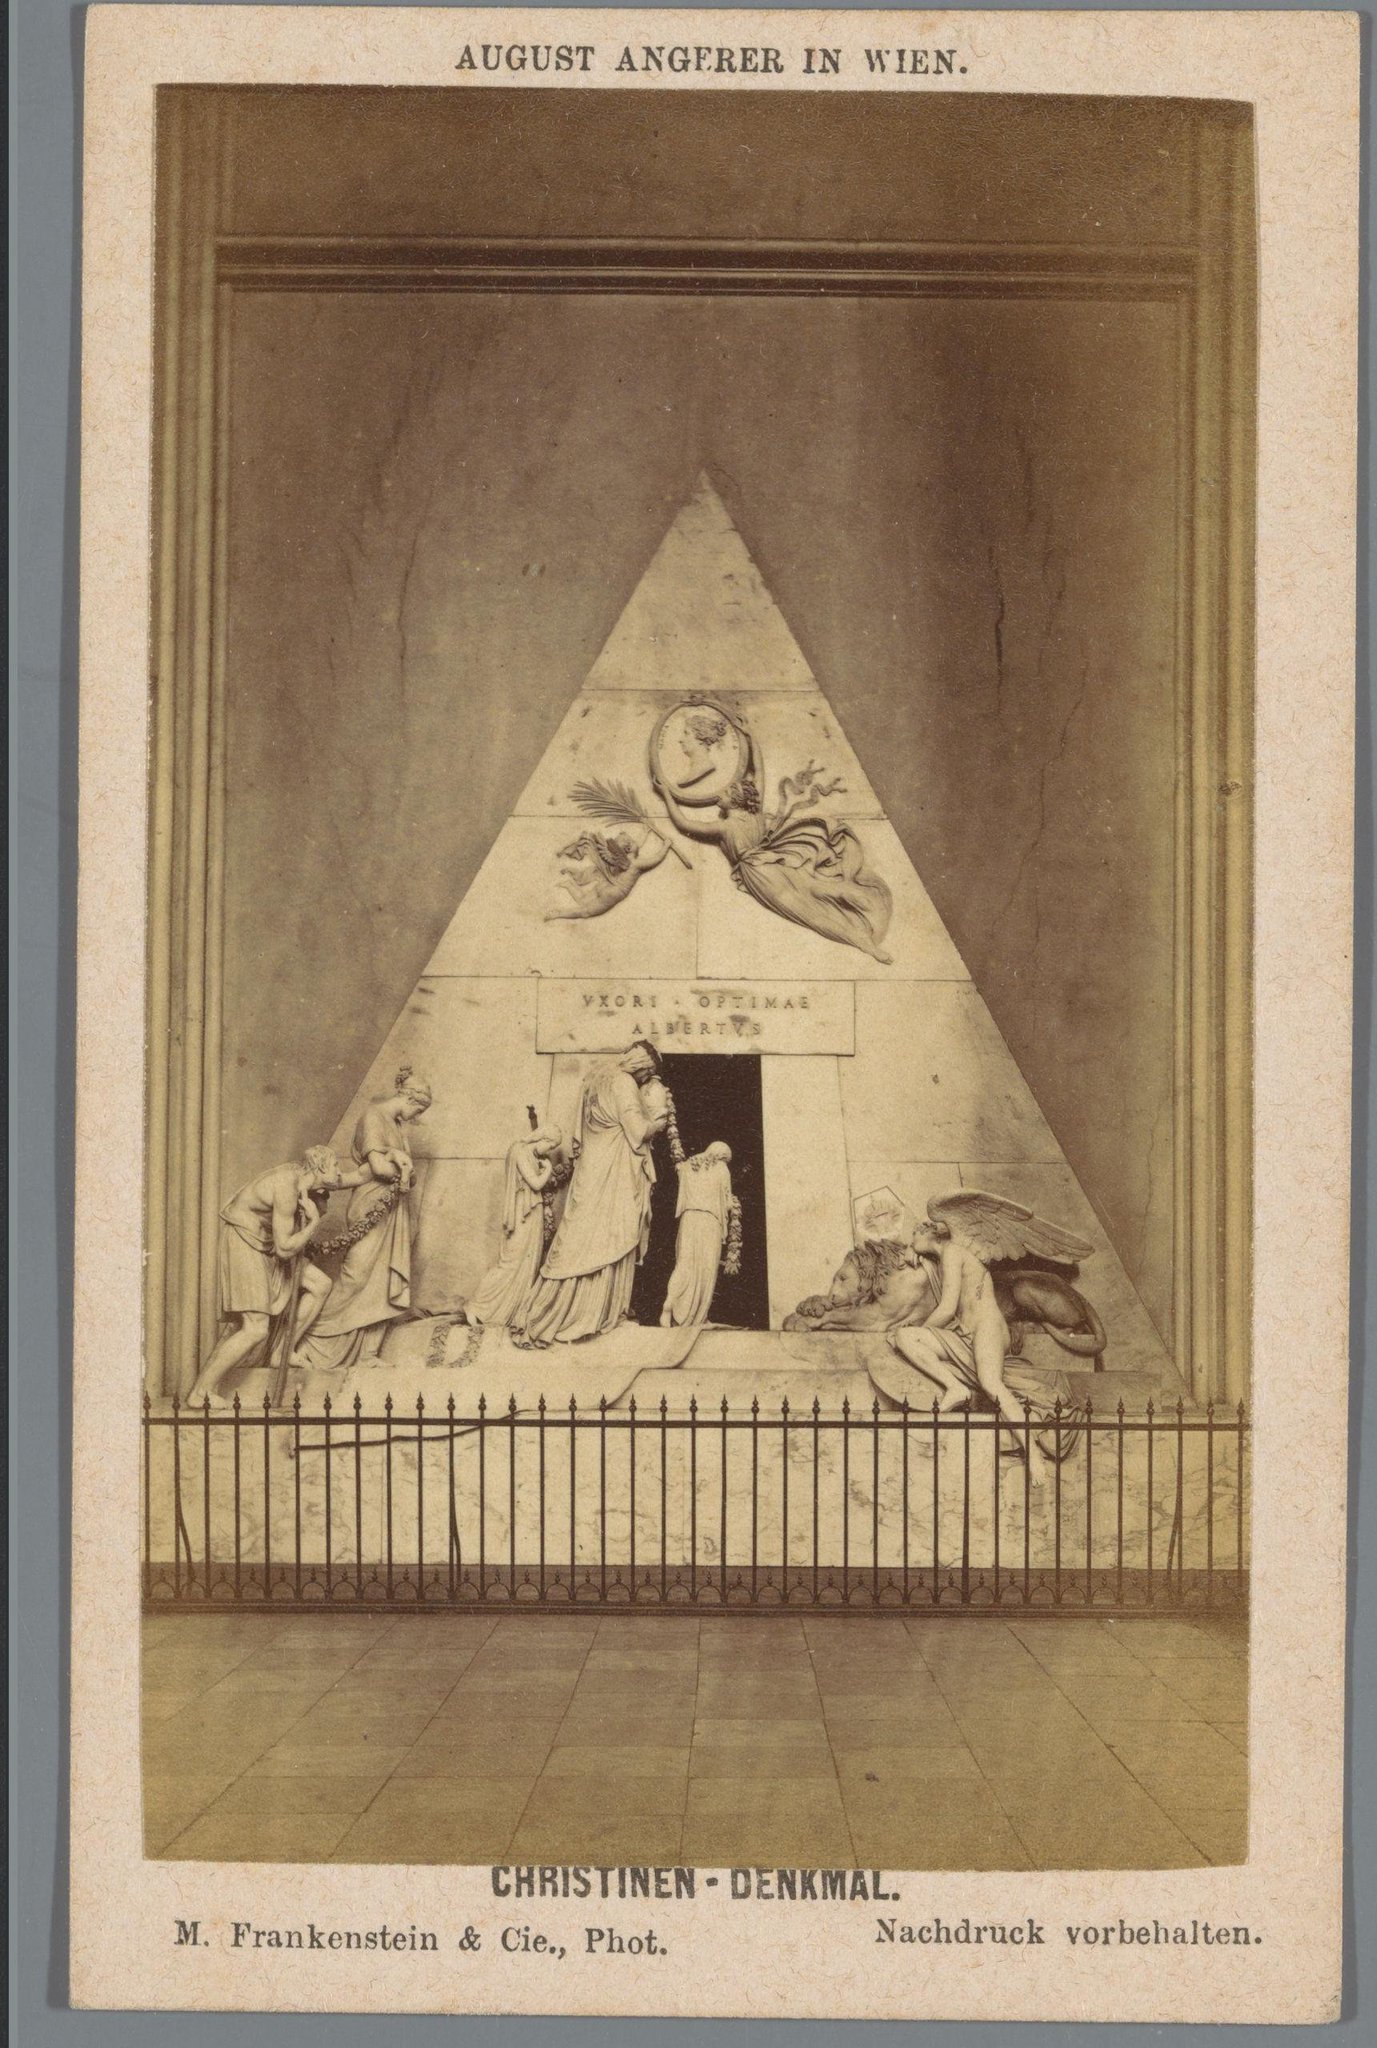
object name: photograph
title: Grafmonument van Maria Christina van Oostenrijk in de Augustinerkirche, Wenen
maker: august angerer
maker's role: publisher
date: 1868-1880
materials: cardboard, paper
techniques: albumen print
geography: vienna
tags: grave, tomb, grave-building, monumental tomb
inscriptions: inscription: ‘Nachdruck vorbehalten.’, inscription: ‘Weenen’